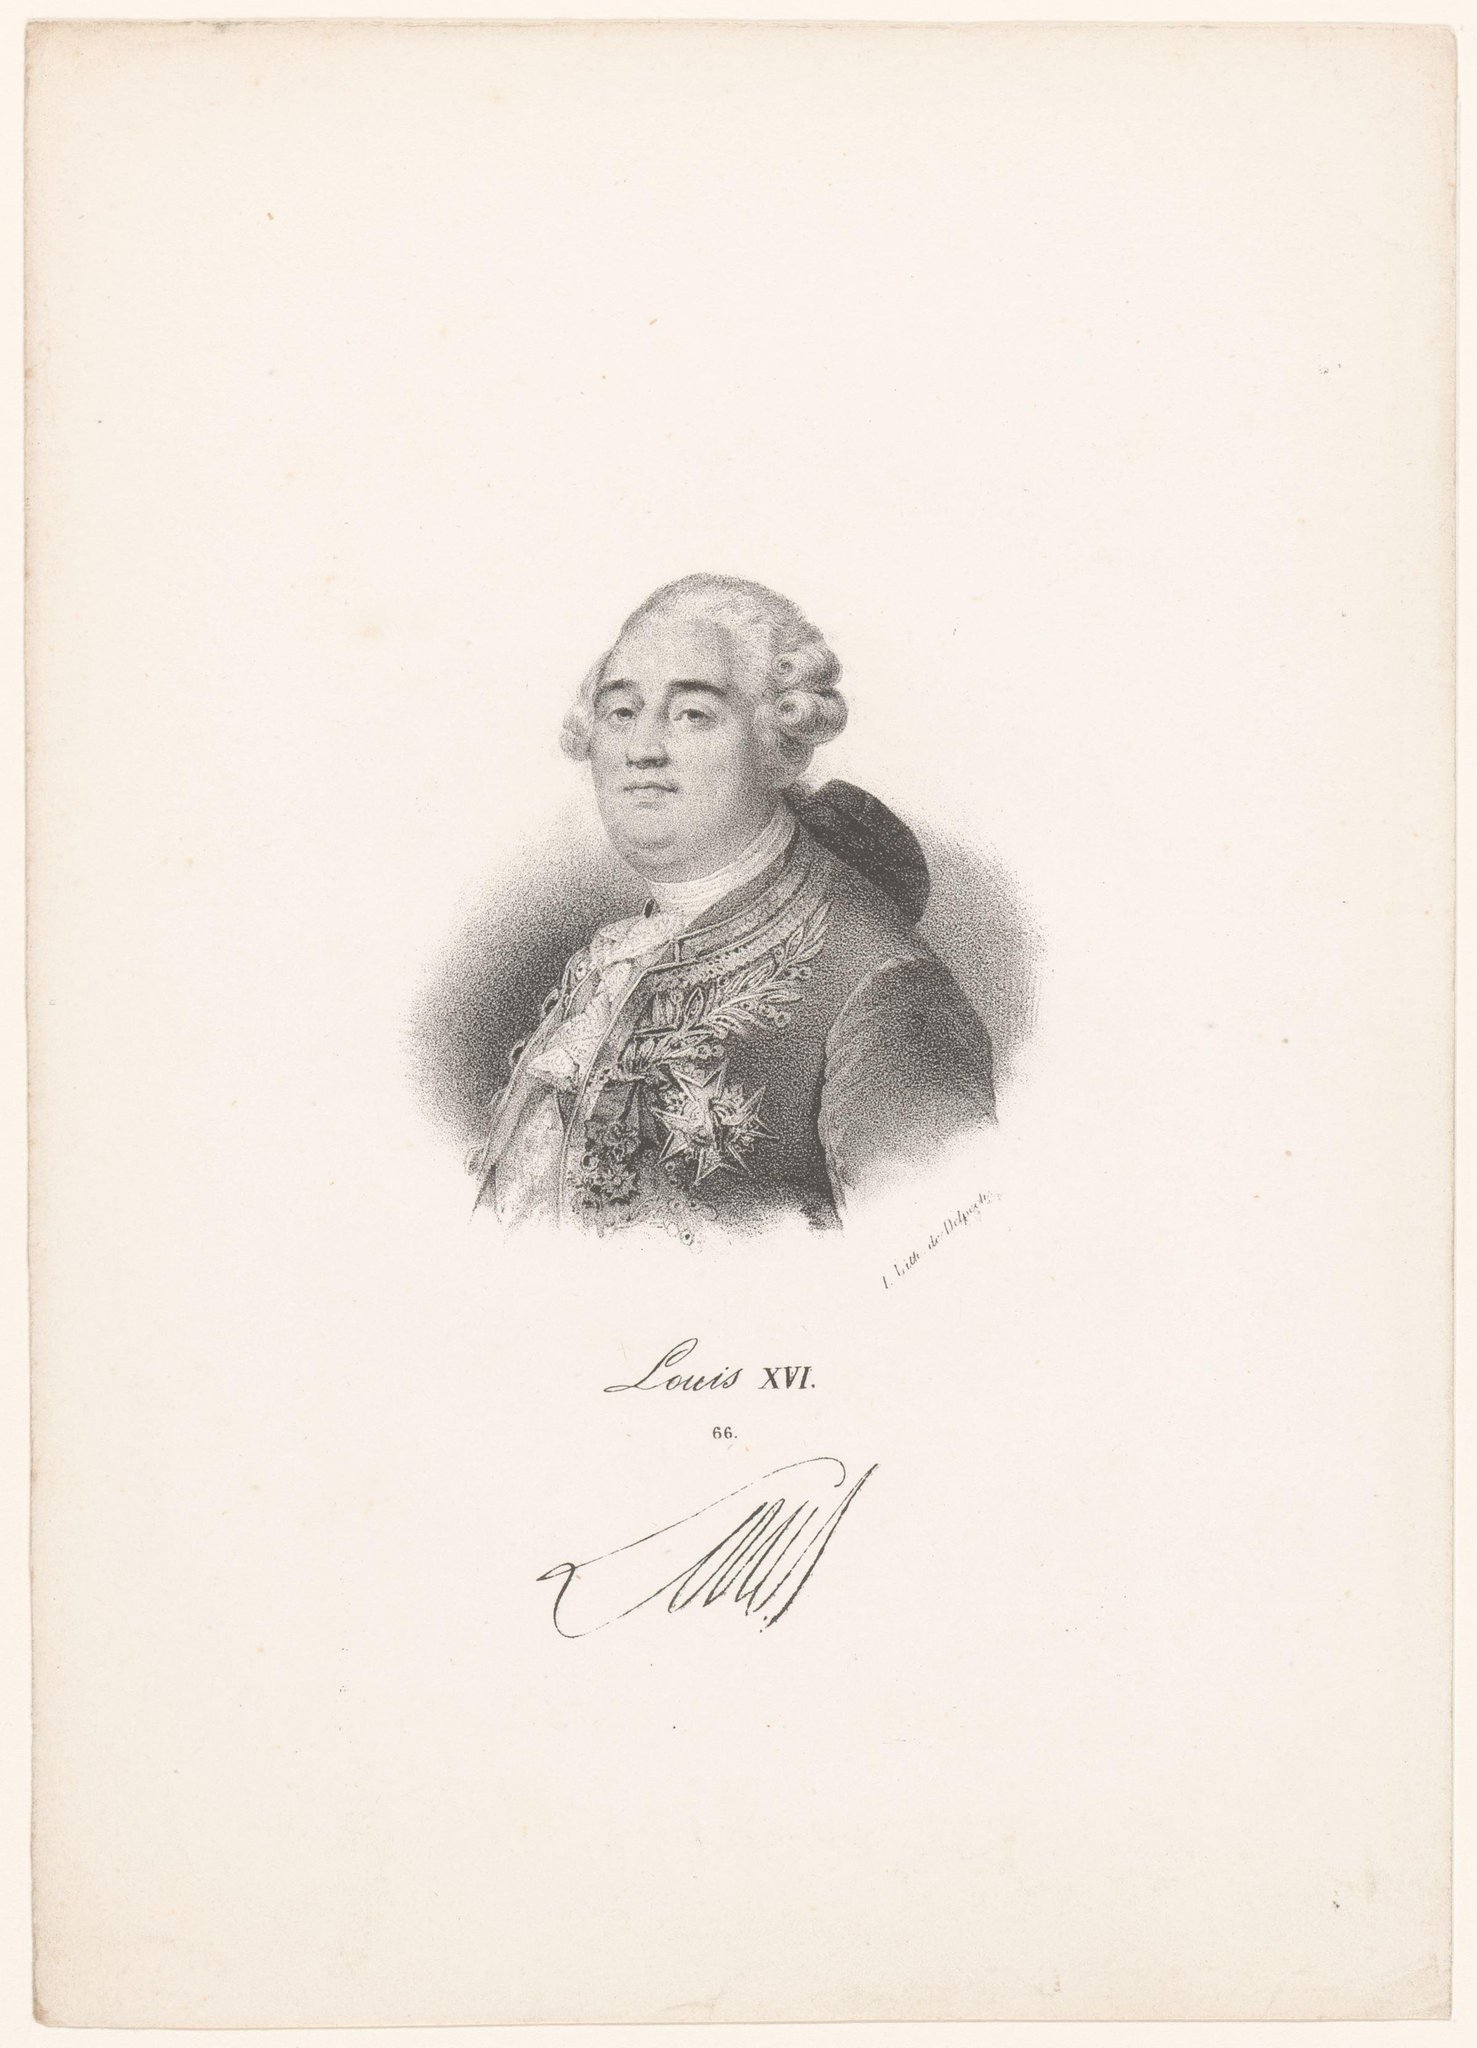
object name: print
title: Portret van Lodewijk XVI van Frankrijk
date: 1818-1842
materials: paper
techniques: lithograph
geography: paris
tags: paris, lodewijk xvi (koning van frankrijk), historical persons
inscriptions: collector's mark: Lugt 2228a